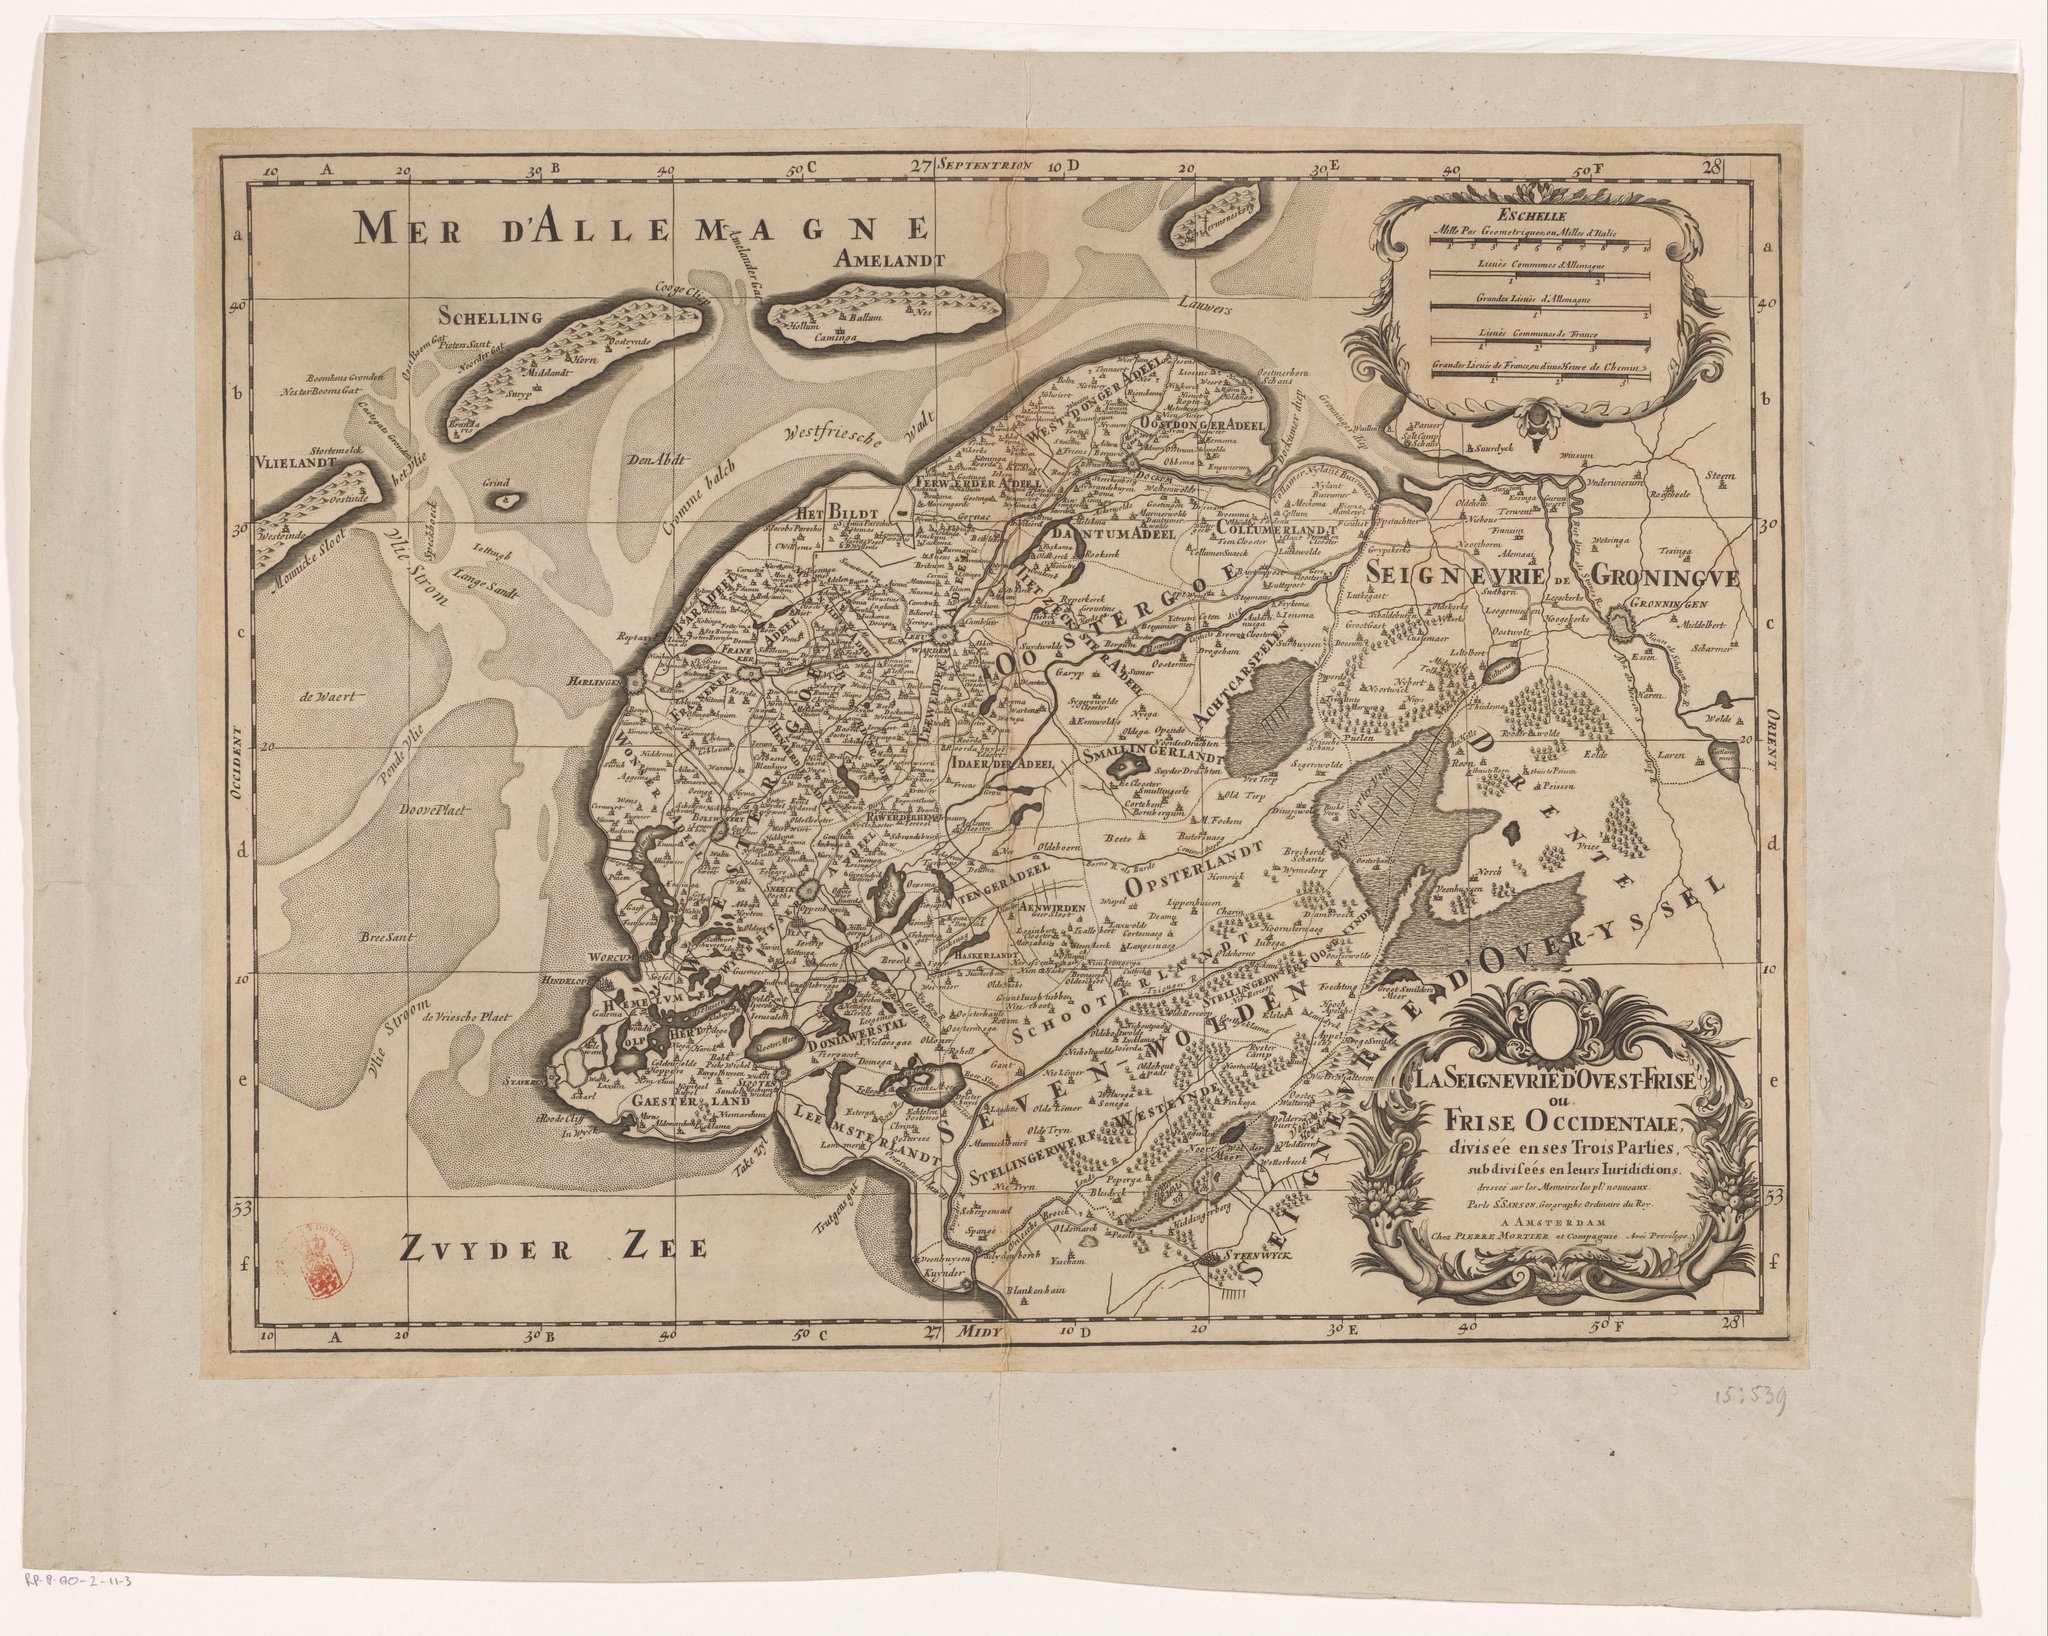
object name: map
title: Kaart van Friesland en een deel van Groningen, Drenthe en Overijssel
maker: pieter mortier (i)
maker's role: publisher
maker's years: 1661-1711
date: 1697-1721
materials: paper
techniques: engraving, hand coloring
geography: amsterdam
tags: maps of separate countries or regions, groningen (province)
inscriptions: collector's mark: Lugt 2228, collector's mark: Lugt 19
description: Prent ook gebruikt in: Atlas nouveau contenant toutes les parties du monde (...). Amsterdam: Pieter Mortier I, ca. 1697-1721. Deze kaart is een Amsterdamse kopie, uitgegeven door Pieter Mortier I, van een Franse kaart uitgegeven door Alexis Hubert Jaillot. Mortier verkreeg in 1690 van de Staten van Holland en West-Friesland voor vijftien jaar het privilege om kopieën van de Franse Jaillot kaarten uit te geven. Mortier graveerde deze kaarten waarschijnlijk zelf.